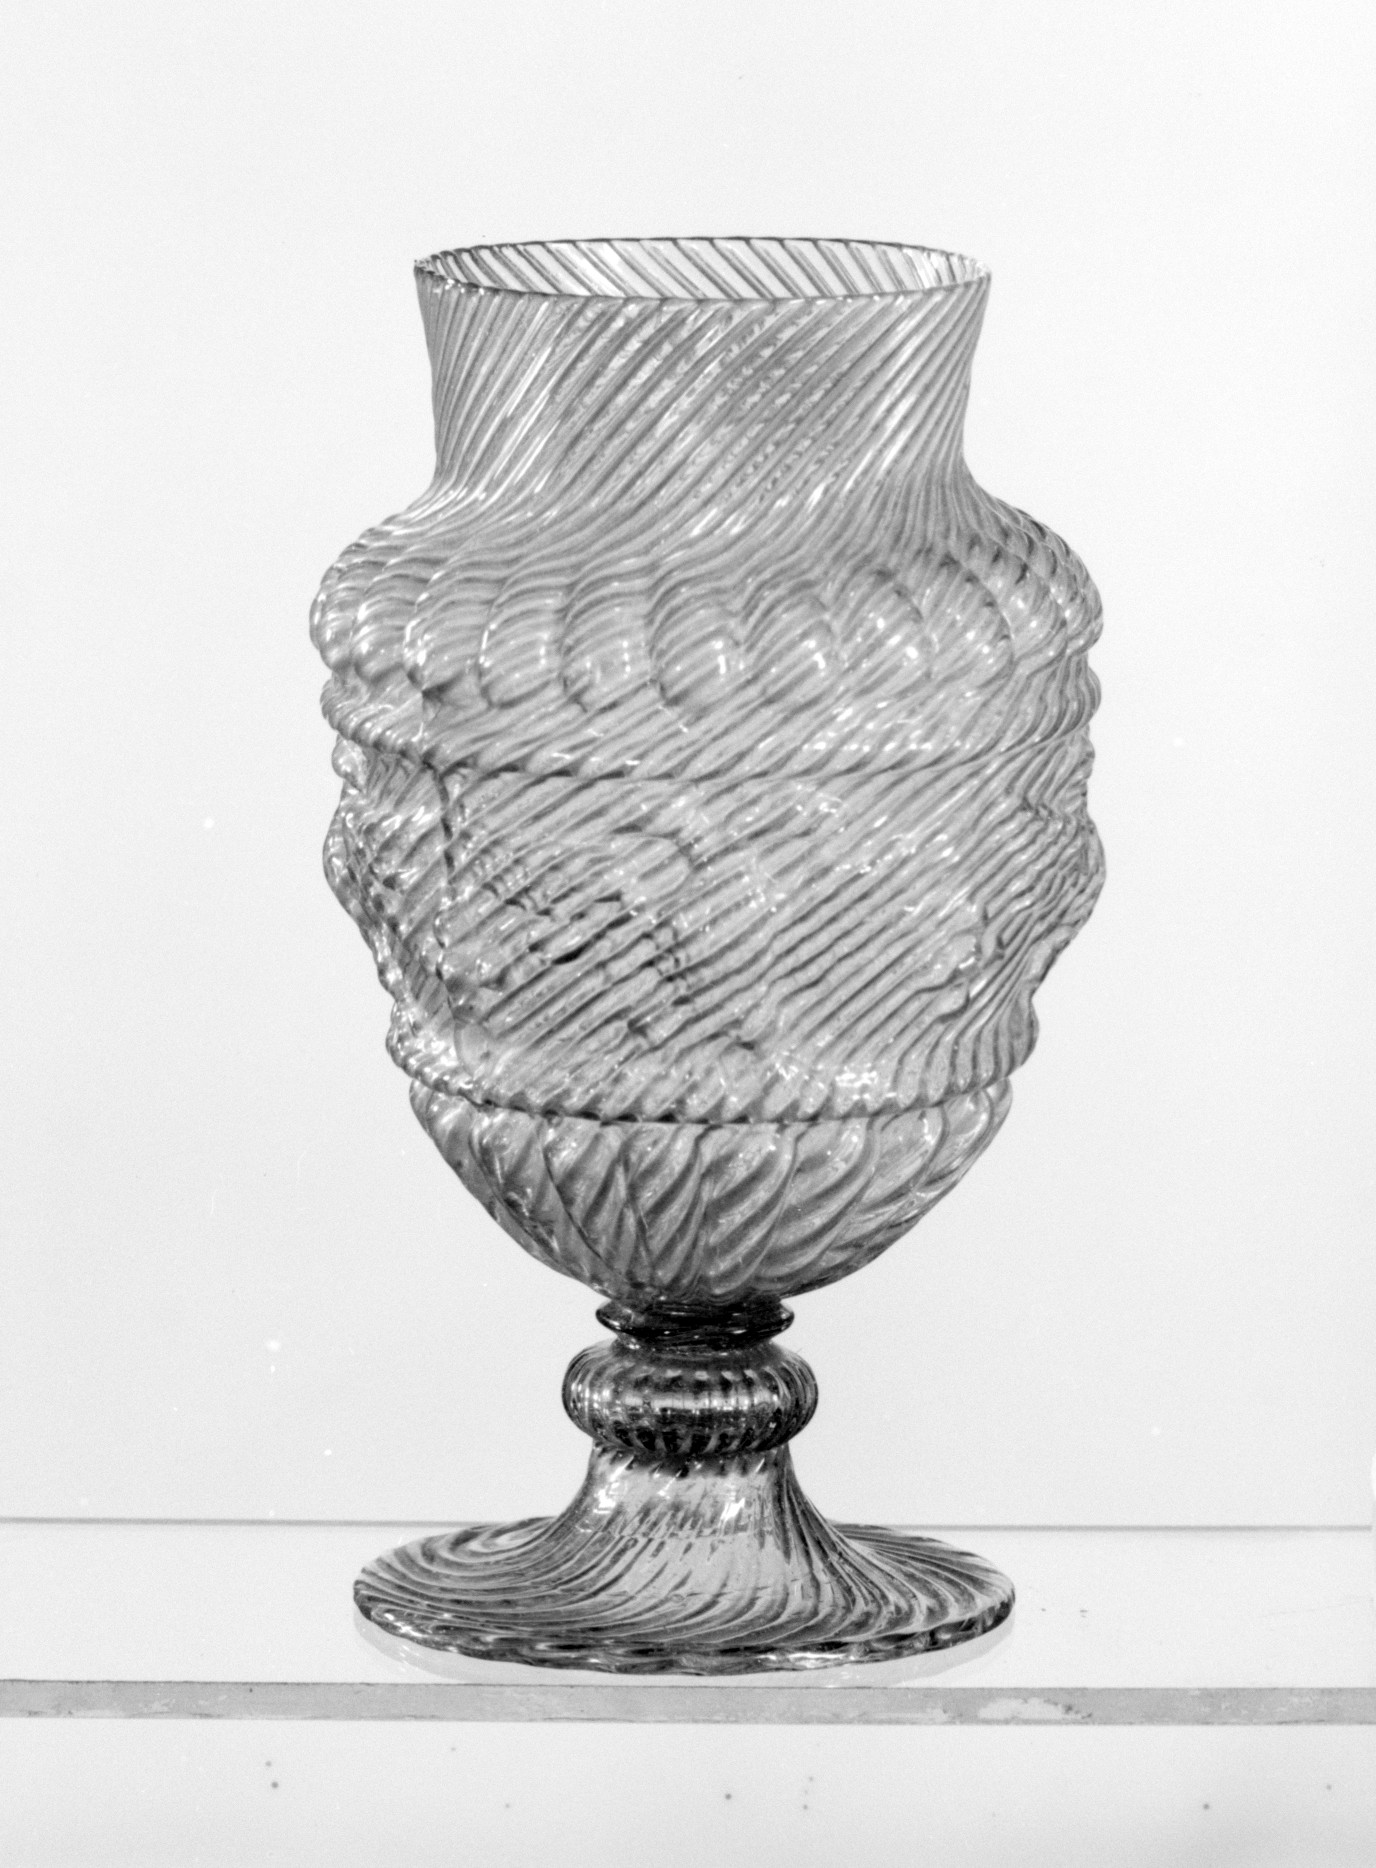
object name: goblet vase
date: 1501-1700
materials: glass